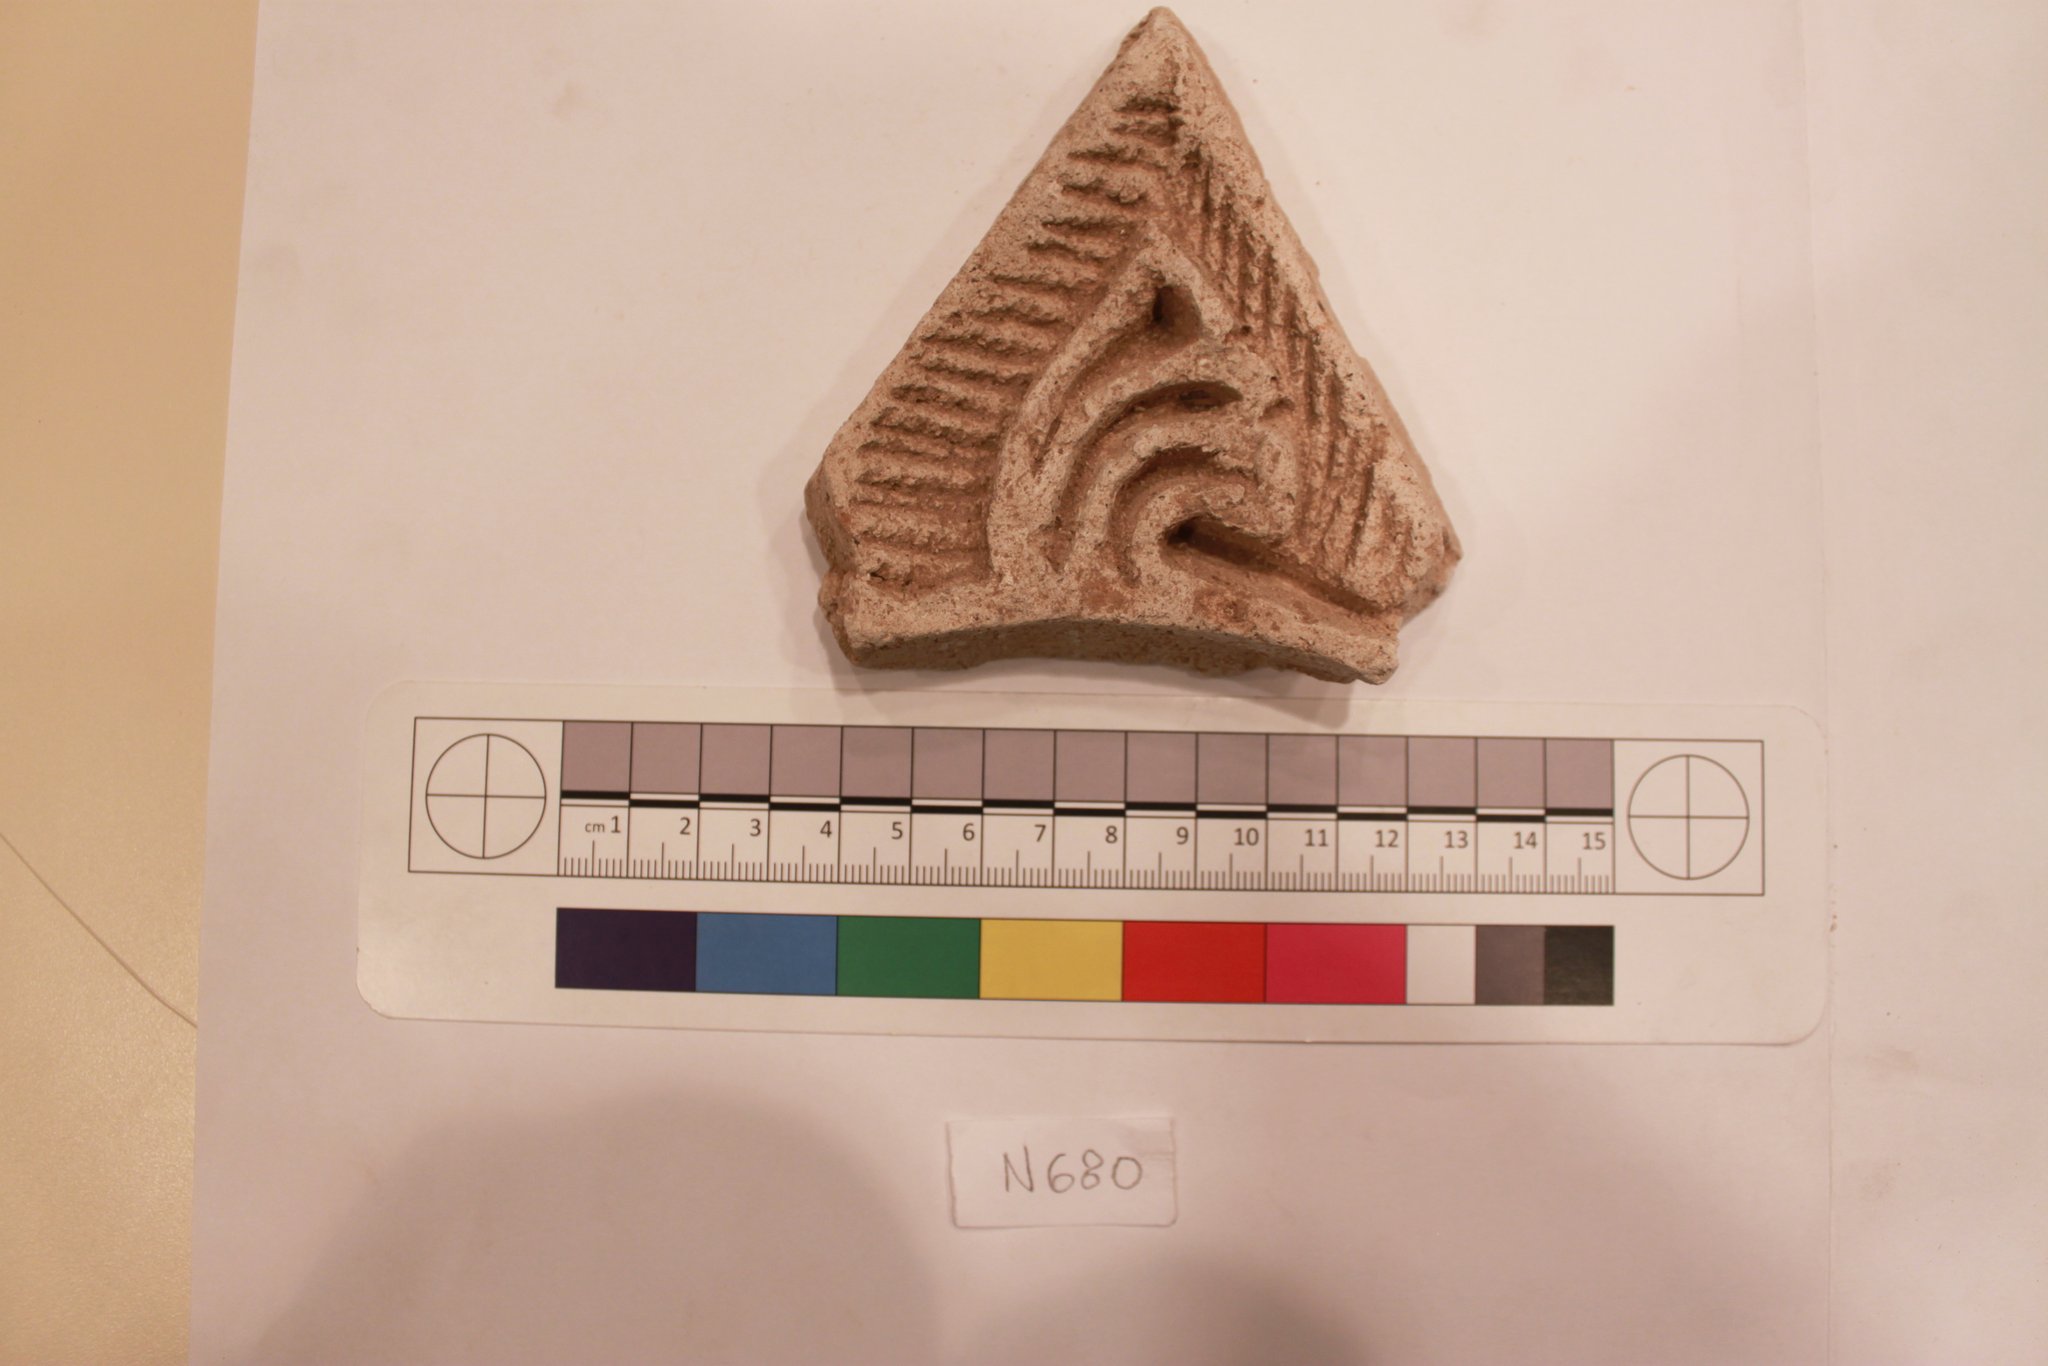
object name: fragment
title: Stucco Fragment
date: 701-1200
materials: plaster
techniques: carving, painting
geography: iran